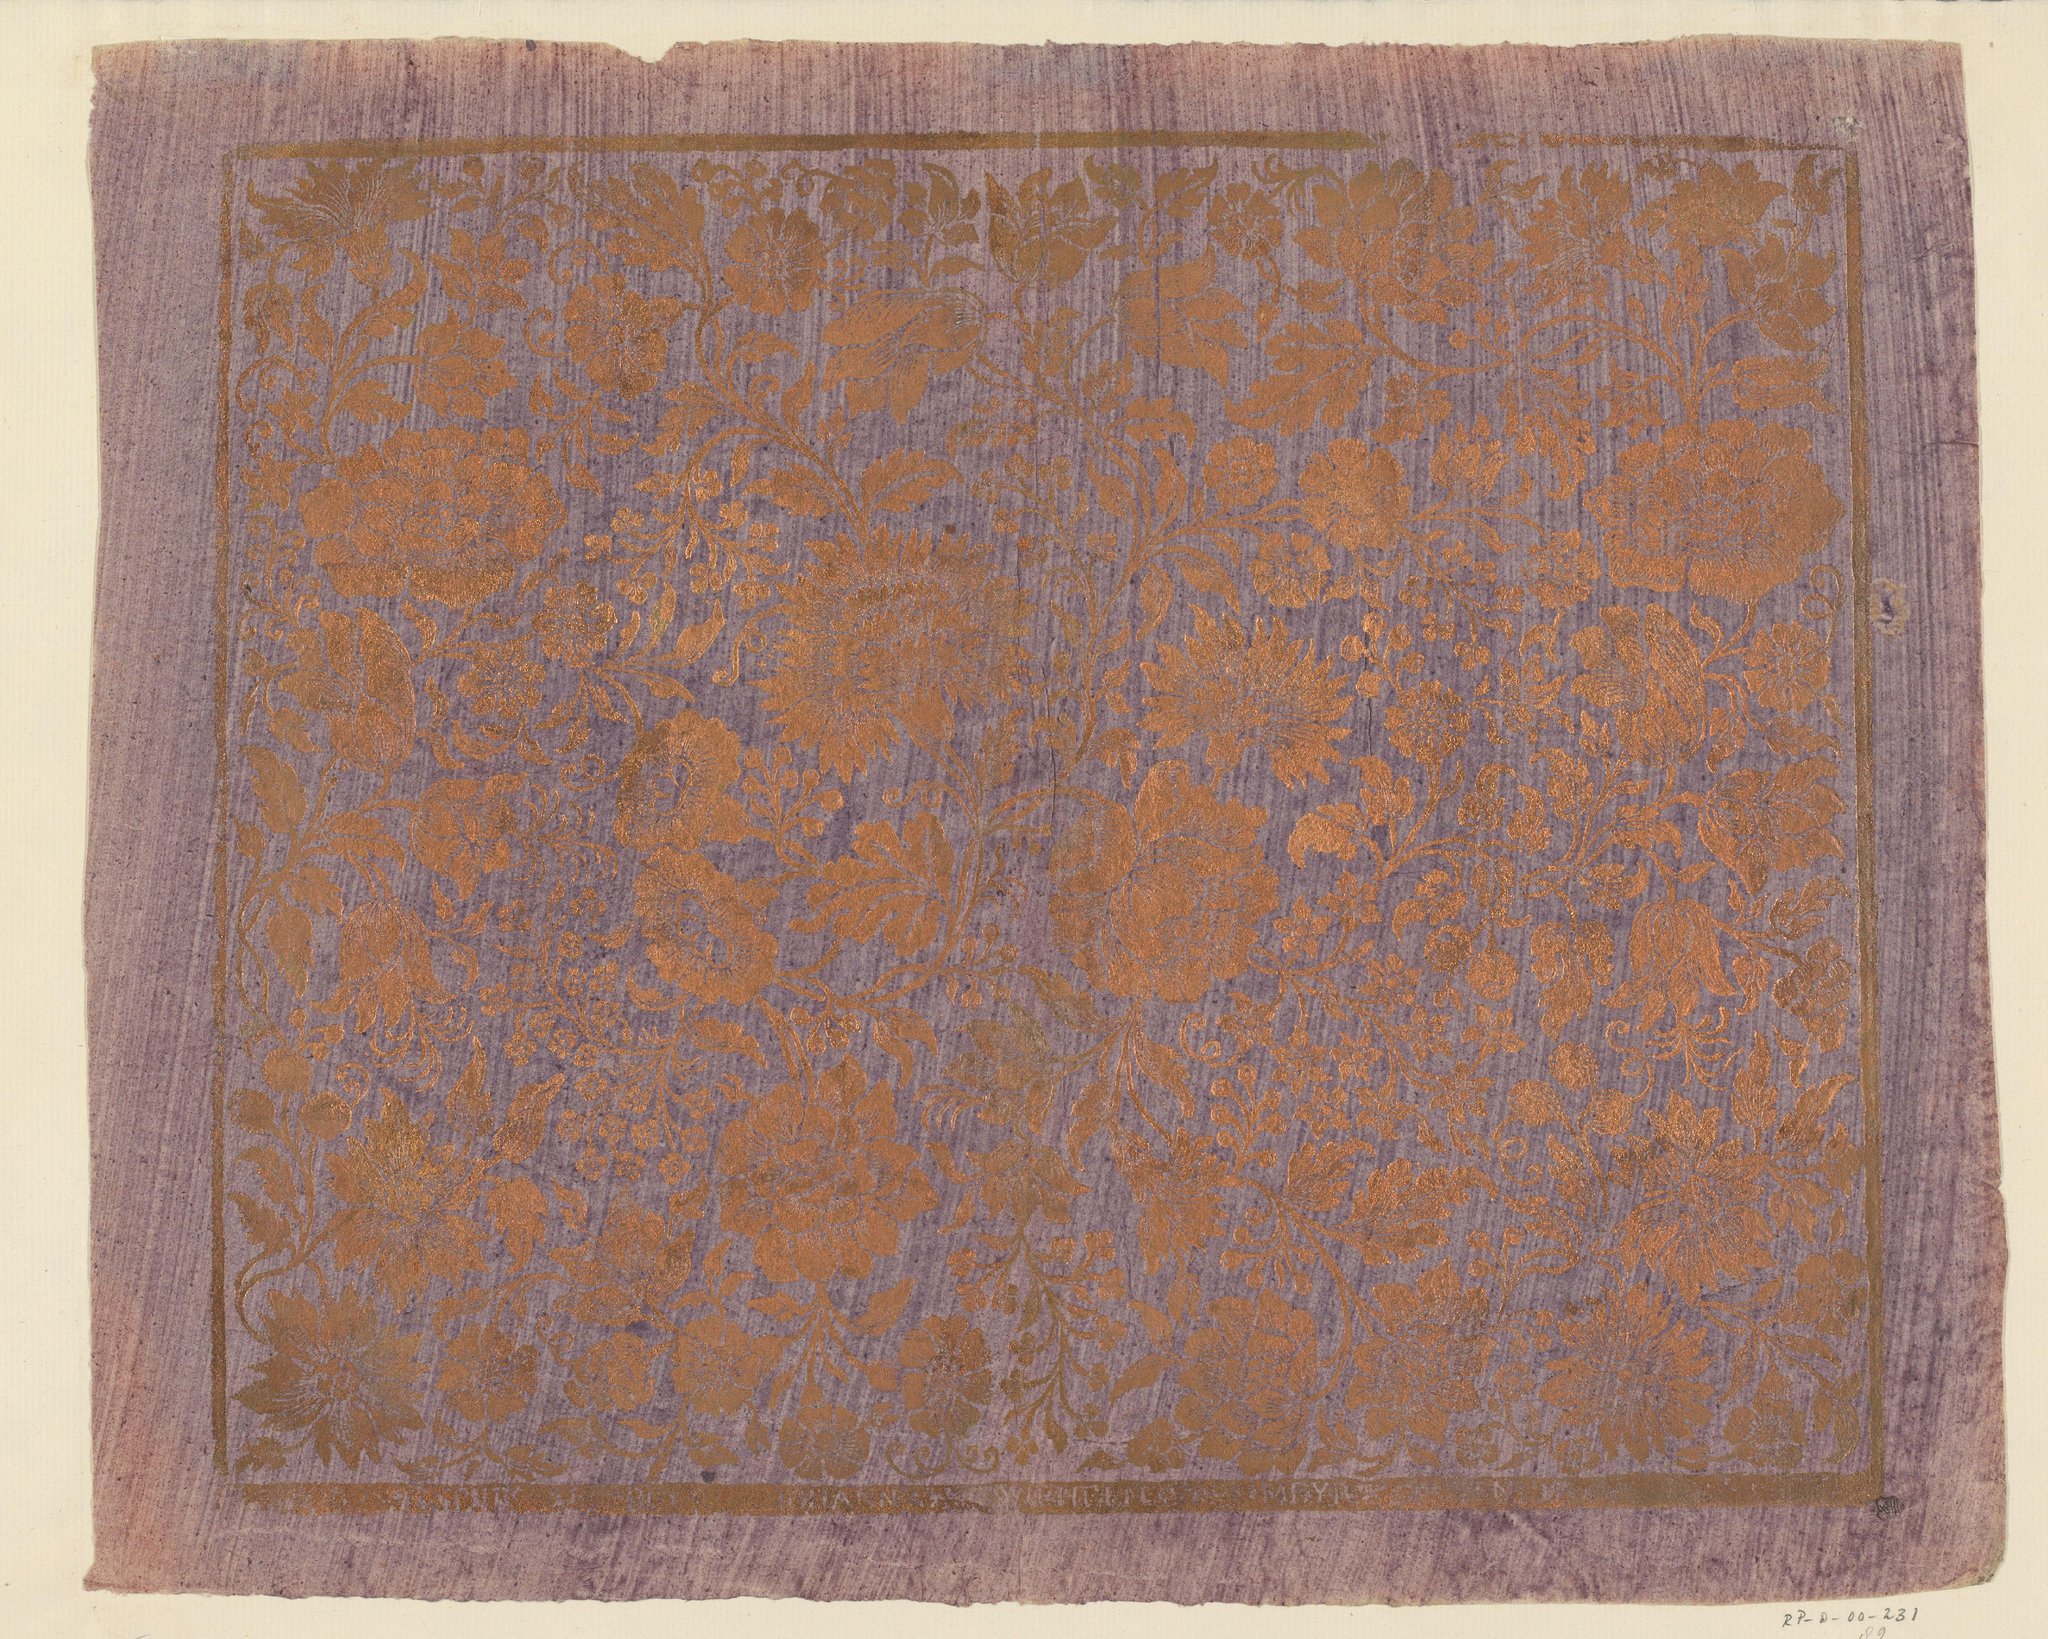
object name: brocade paper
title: Blad met ranken met bloemen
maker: johann wilhelm meyer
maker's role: papiermaker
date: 1740-1780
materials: gold leaf, paint, paper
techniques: relief print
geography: augsburg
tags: ornament derived from plant forms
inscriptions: collector's mark: Lugt 2760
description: Blad met ranken met grote en kleine bloemen. Genummerd onderaan: No 17.